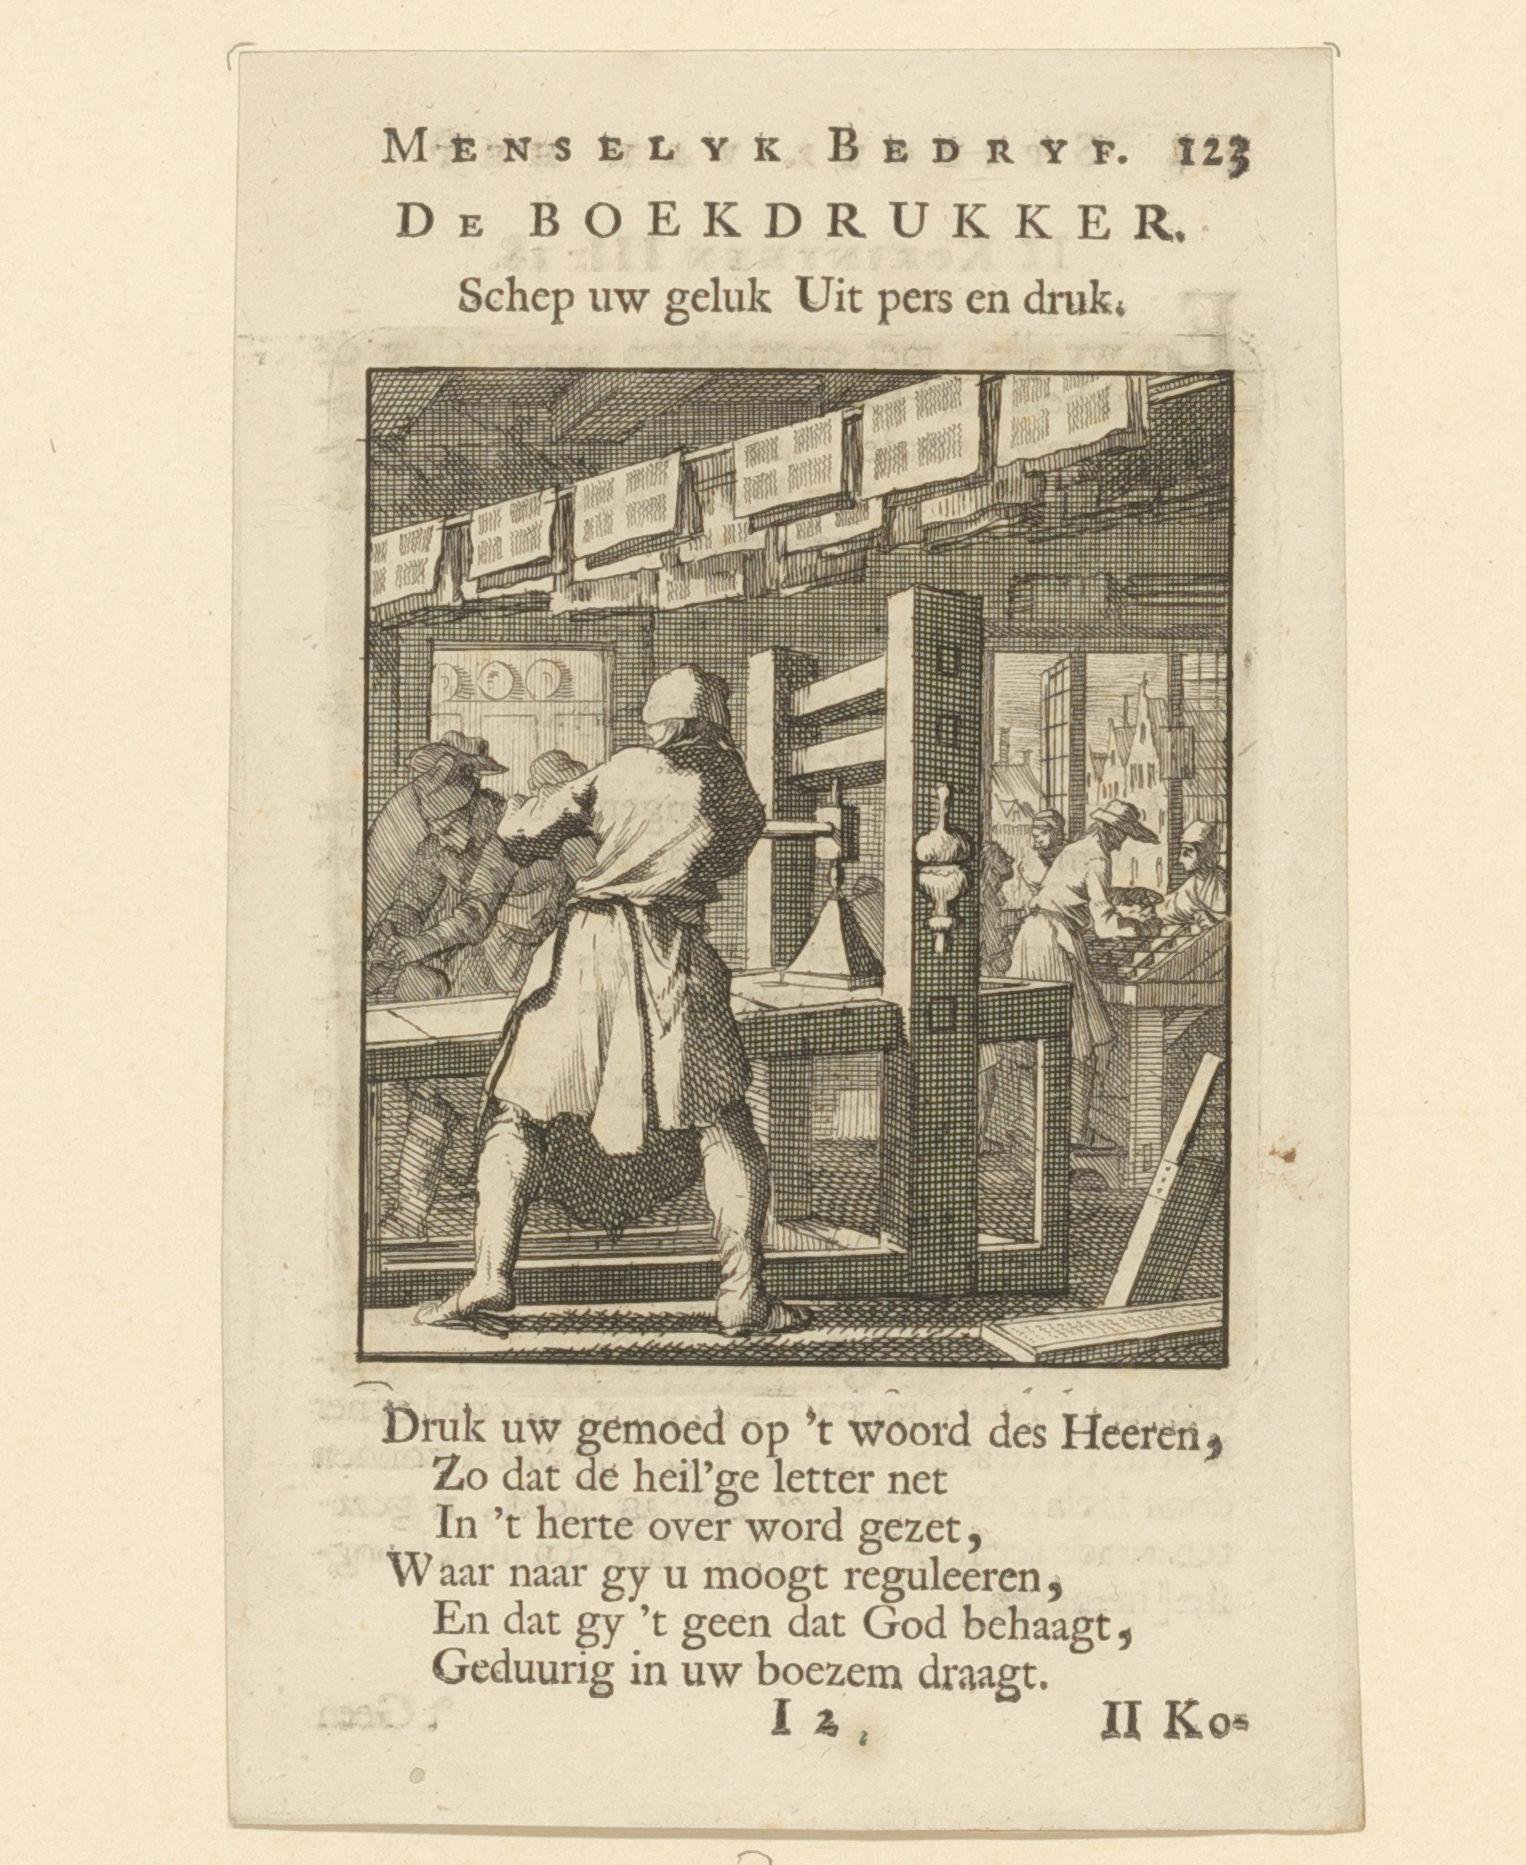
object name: book illustration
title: De Boekdrukker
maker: cornelis van der sys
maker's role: publisher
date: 1718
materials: paper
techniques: etching, letterpress printing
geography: amsterdam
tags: handicrafts, craftsman at work, printer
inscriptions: stamp, stamp, collector's mark: Lugt 1641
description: Prent oorspronkelijk verschenen in de 100-delige serie beroepsprenten van Jan en Caspar Luyken, getiteld: Het menselyk bedryf. S.l.s.n., 1694 (eerste druk). Daarna is de titel en het vers afgesneden. De prenten in diverse publicaties verschenen en gekopieerd. Huidige staat uit: Luyken, Jan en Caspar. Spiegel van het menselyk bedryf (...). Amsterdam: Cornelis van der Sys, 1718, p. 123. Prent waarschijnlijk ook gebruikt in eerdere (1704) en latere (1730, 1749, 1767) publicaties.